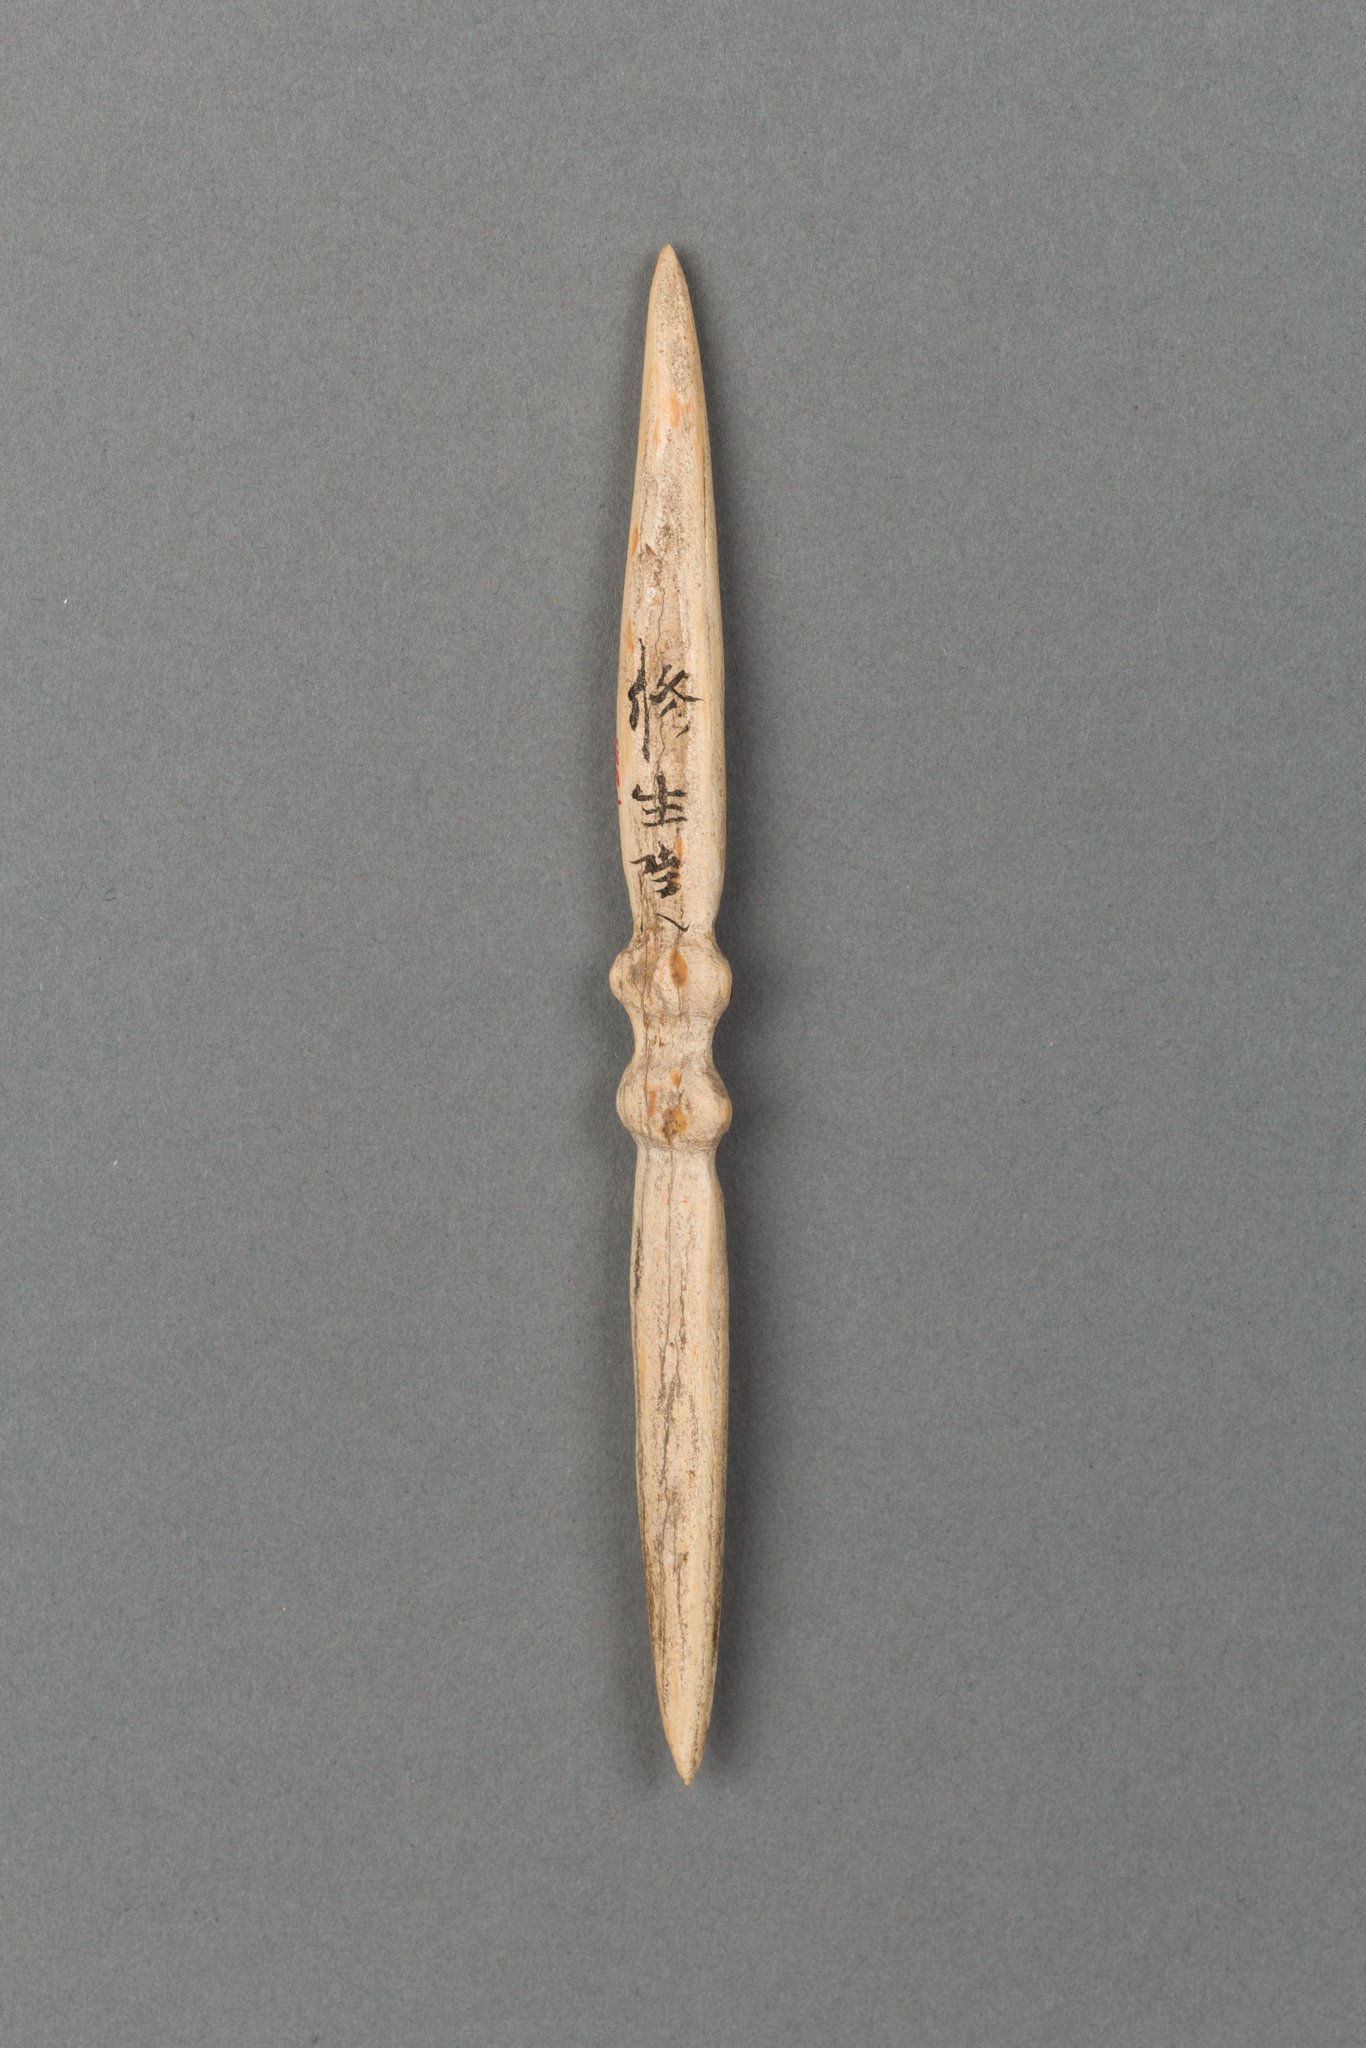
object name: body ornament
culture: japanese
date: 1000-300 BCE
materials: bone